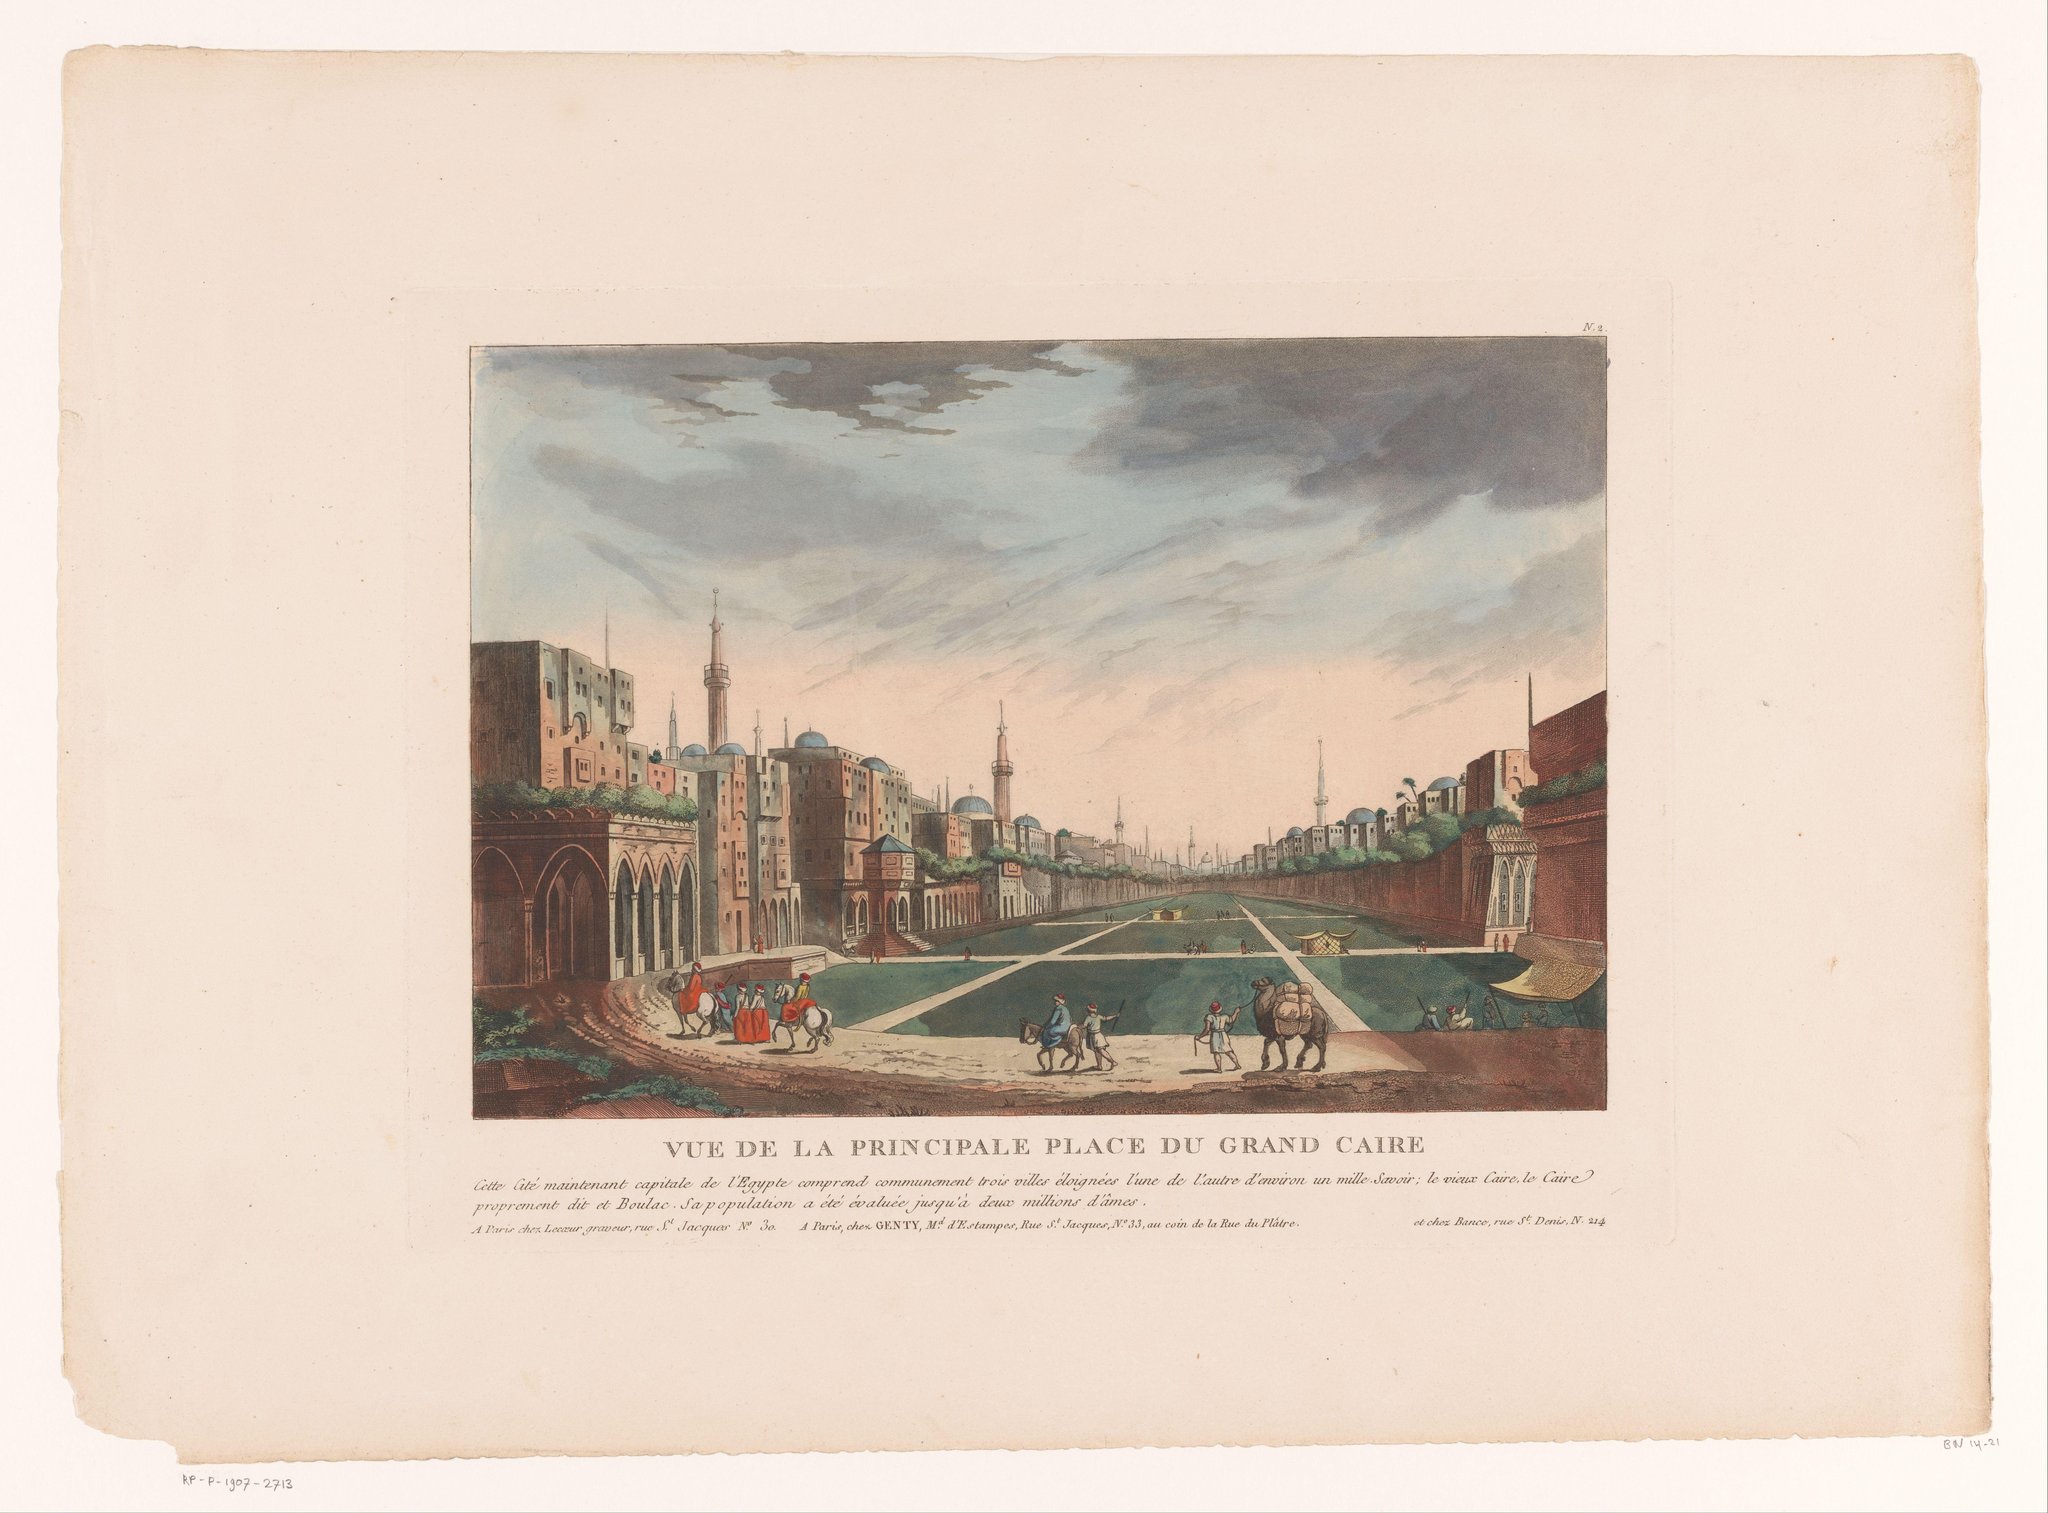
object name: print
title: Vue de la Principale Place du Grand Caire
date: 1812-1814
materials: paper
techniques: aquatint, etching, hand coloring, roulette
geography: paris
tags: hoofed animals: camel, square, place, circus, etc., city-view in general; 'veduta'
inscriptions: collector's mark: Lugt 2228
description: Maakt mogelijk deel uit van een serie met stadsgezichten in Italië, Spanje en Egypte.